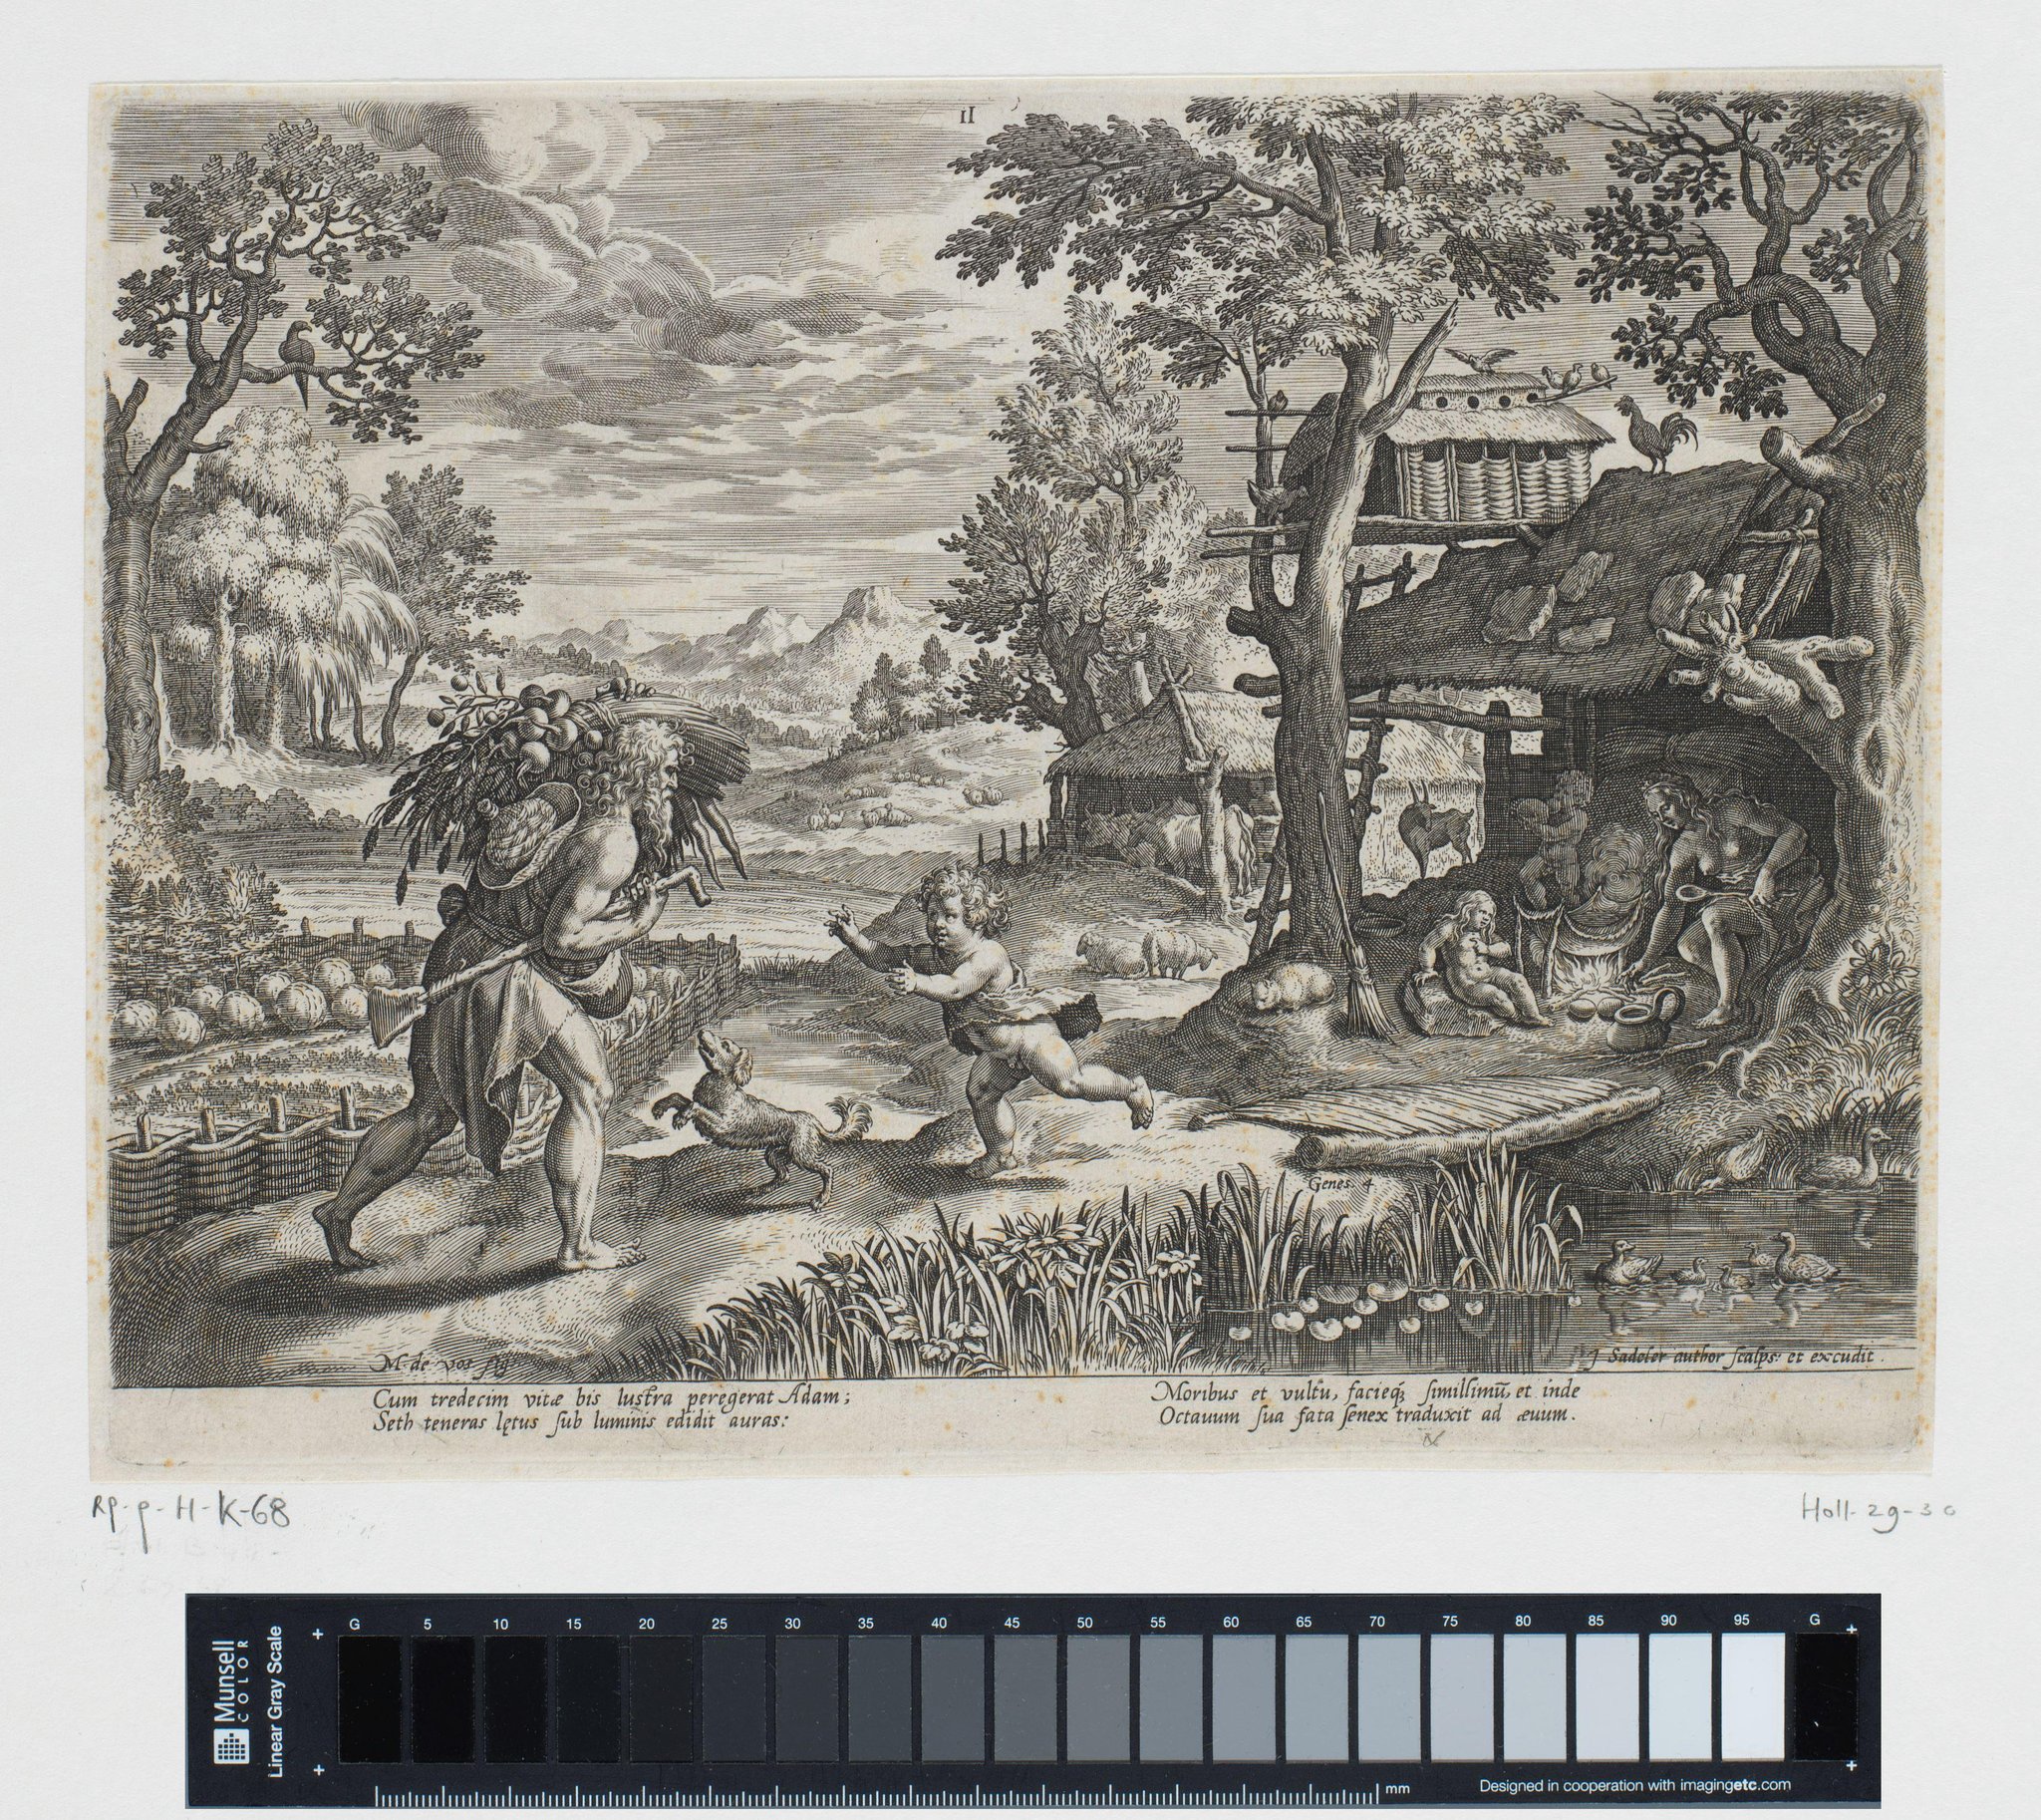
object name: print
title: Set begroet Adam bij diens terugkomst van het veld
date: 1586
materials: paper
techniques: engraving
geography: antwerp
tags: story of seth, declining years and death of adam and eve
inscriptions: collector's mark: Lugt 11, collector's mark: Lugt 10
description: Adam komt terug van zijn werk op de velden met op zijn schouder de dagelijkse oogst. Set, de jongste zoon van Adam, rent zijn vader tegemoet. Links maakt Eva het avondeten klaar in een hut. De prent heeft een Latijns onderschrift.